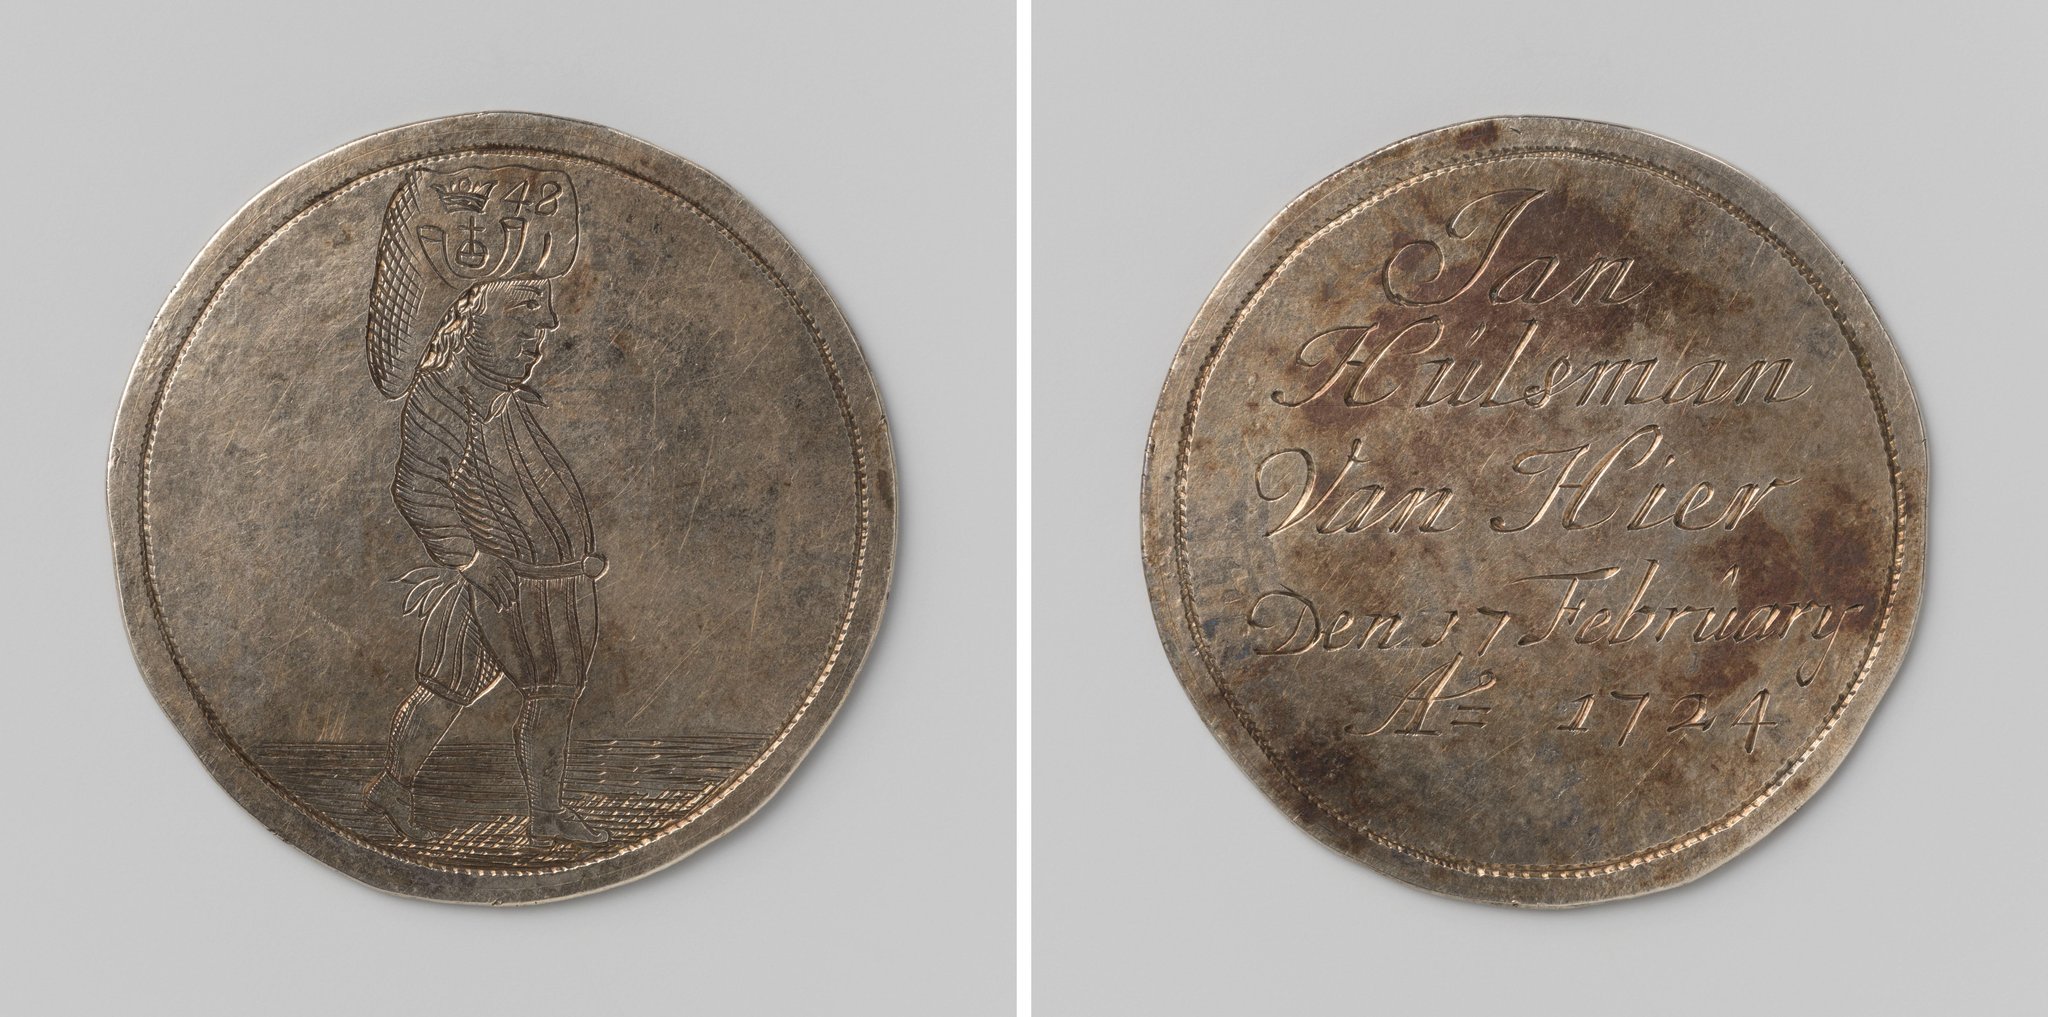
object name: medal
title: Korendragers- en -stortersgilde van Amsterdam, gildepenning van Jan Hulsman van hier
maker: Anonymous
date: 1724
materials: silver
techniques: engraving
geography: amsterdam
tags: amsterdam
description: Guilds were urban organisations of people in specific occupations. The guild represented the interests of the profession. Each member had a token as proof of membership. The person’s name was engraved on one side of the token, often together with the arms of the guild or of the city in which it was based. The other side carried a motif signifying the occupation represented by the guild.